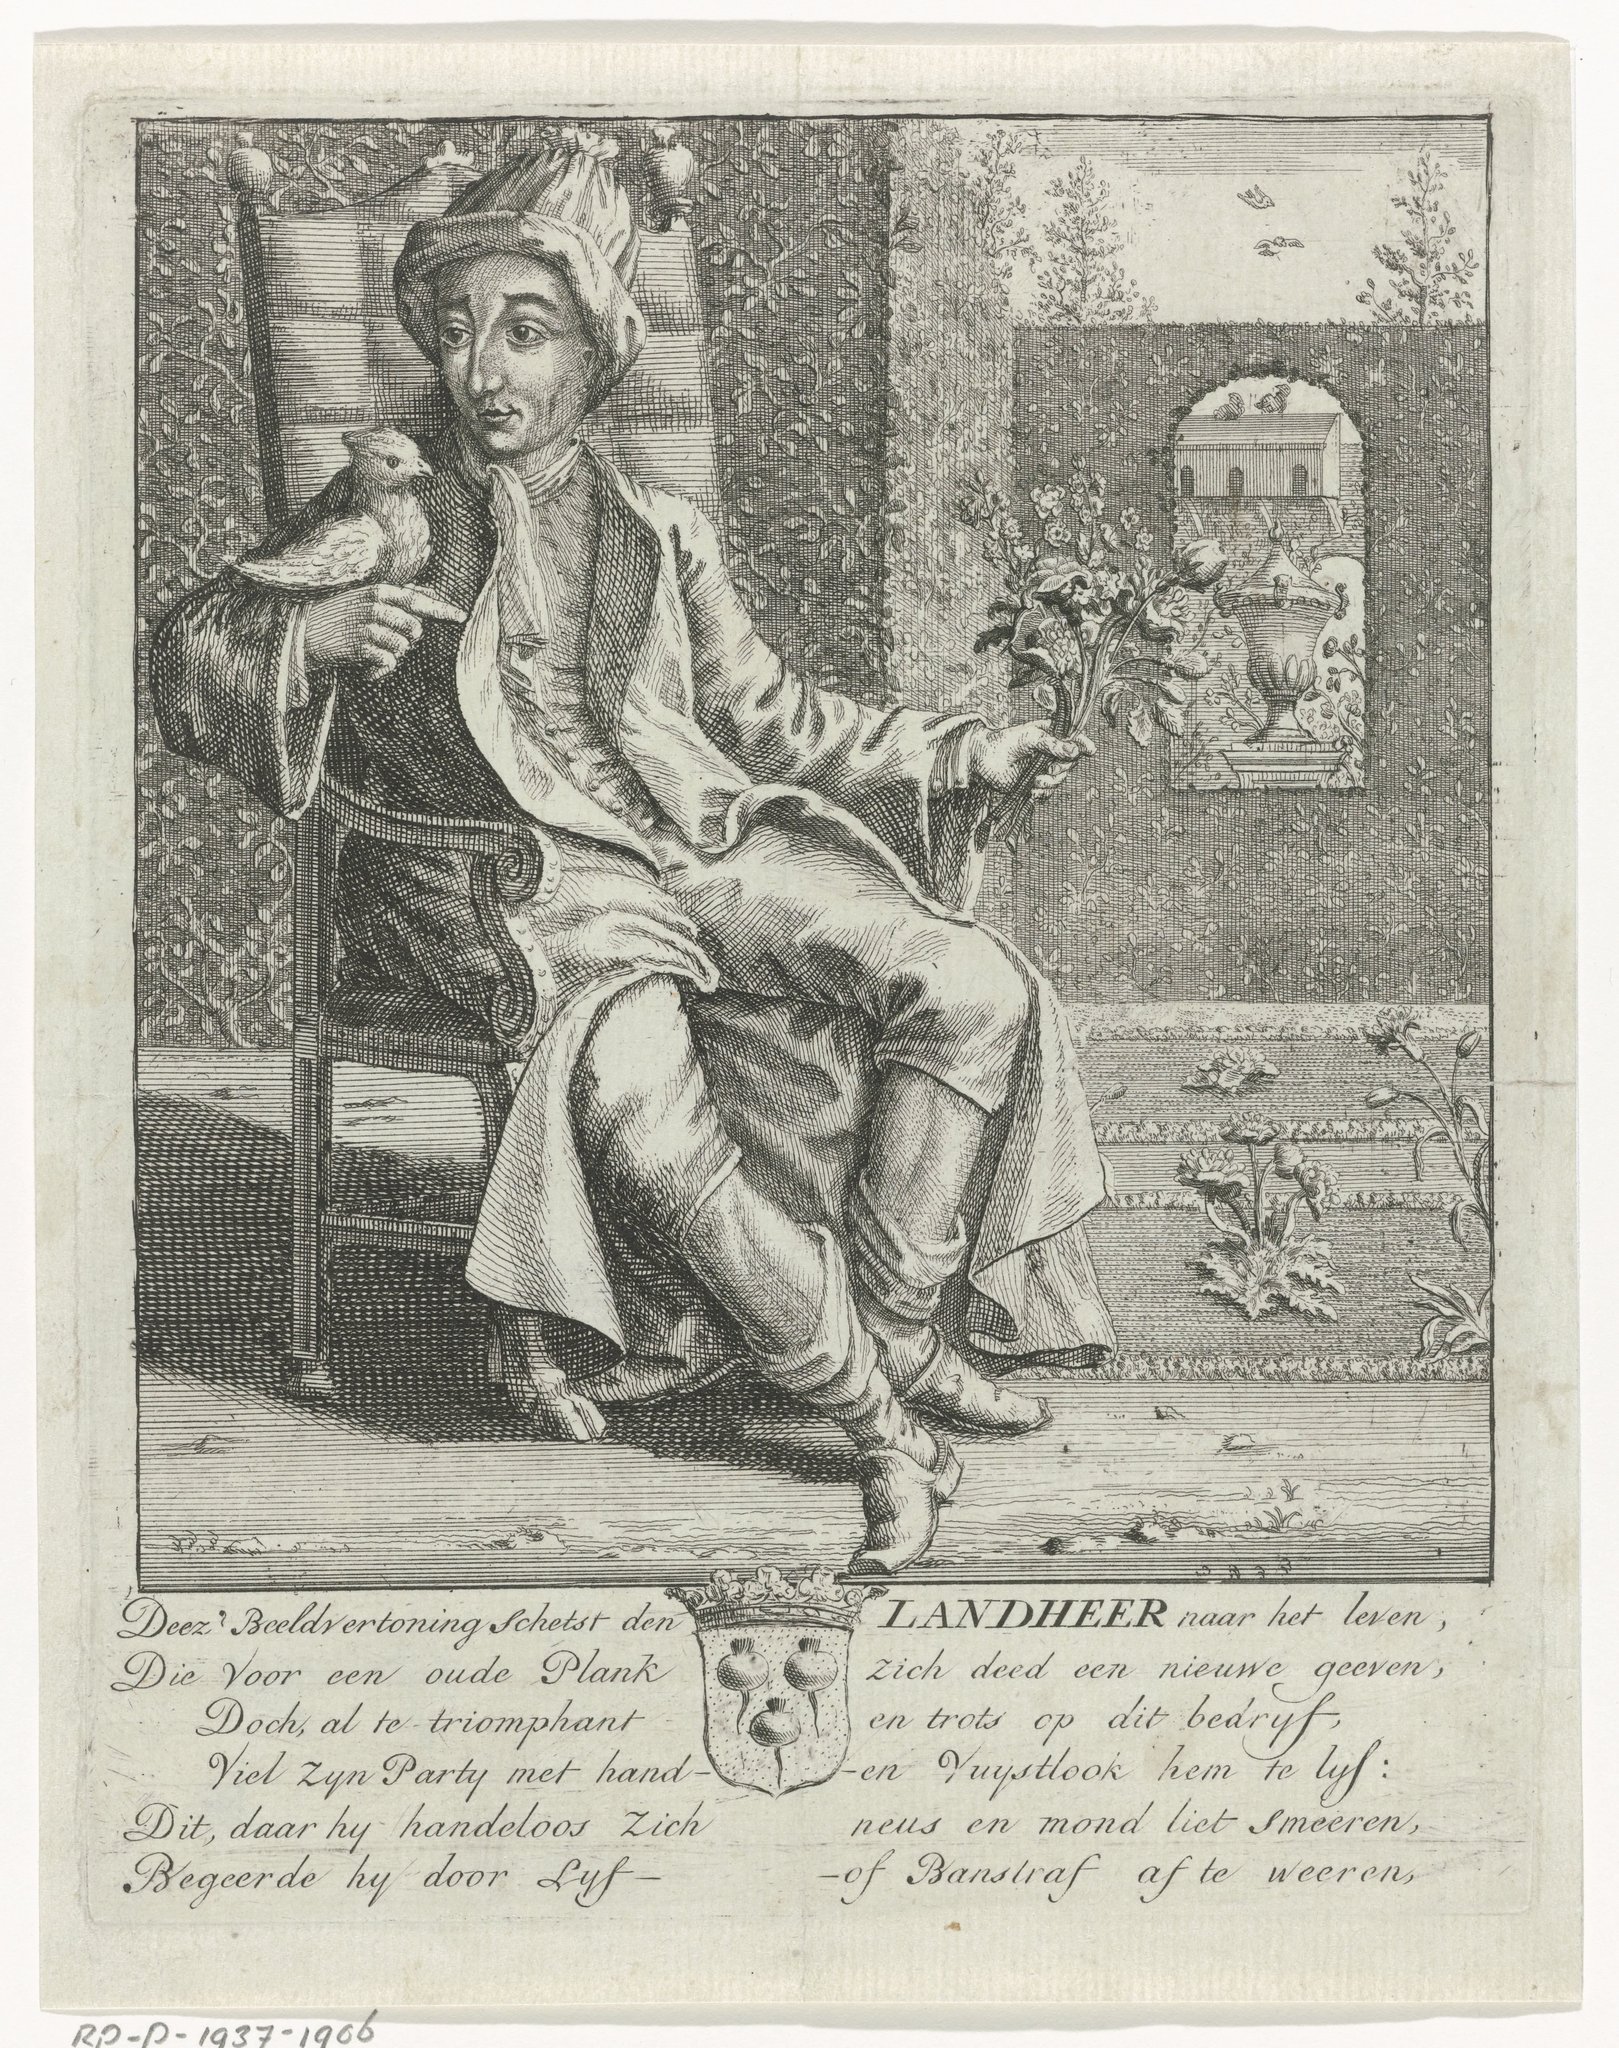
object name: print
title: Landheer zittende in een tuin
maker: Anonymous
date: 1700-1800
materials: paper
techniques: engraving, etching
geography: netherlands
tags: garden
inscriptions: collector's mark: Lugt 2760, collector's mark: Lugt 2228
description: Een landheer gezeten in een stoel in een tuin met in de ene hand een bos bloemen en in de andere hand een vogel. Onder de voorstelling een vers over de landheer en een wapenschild.